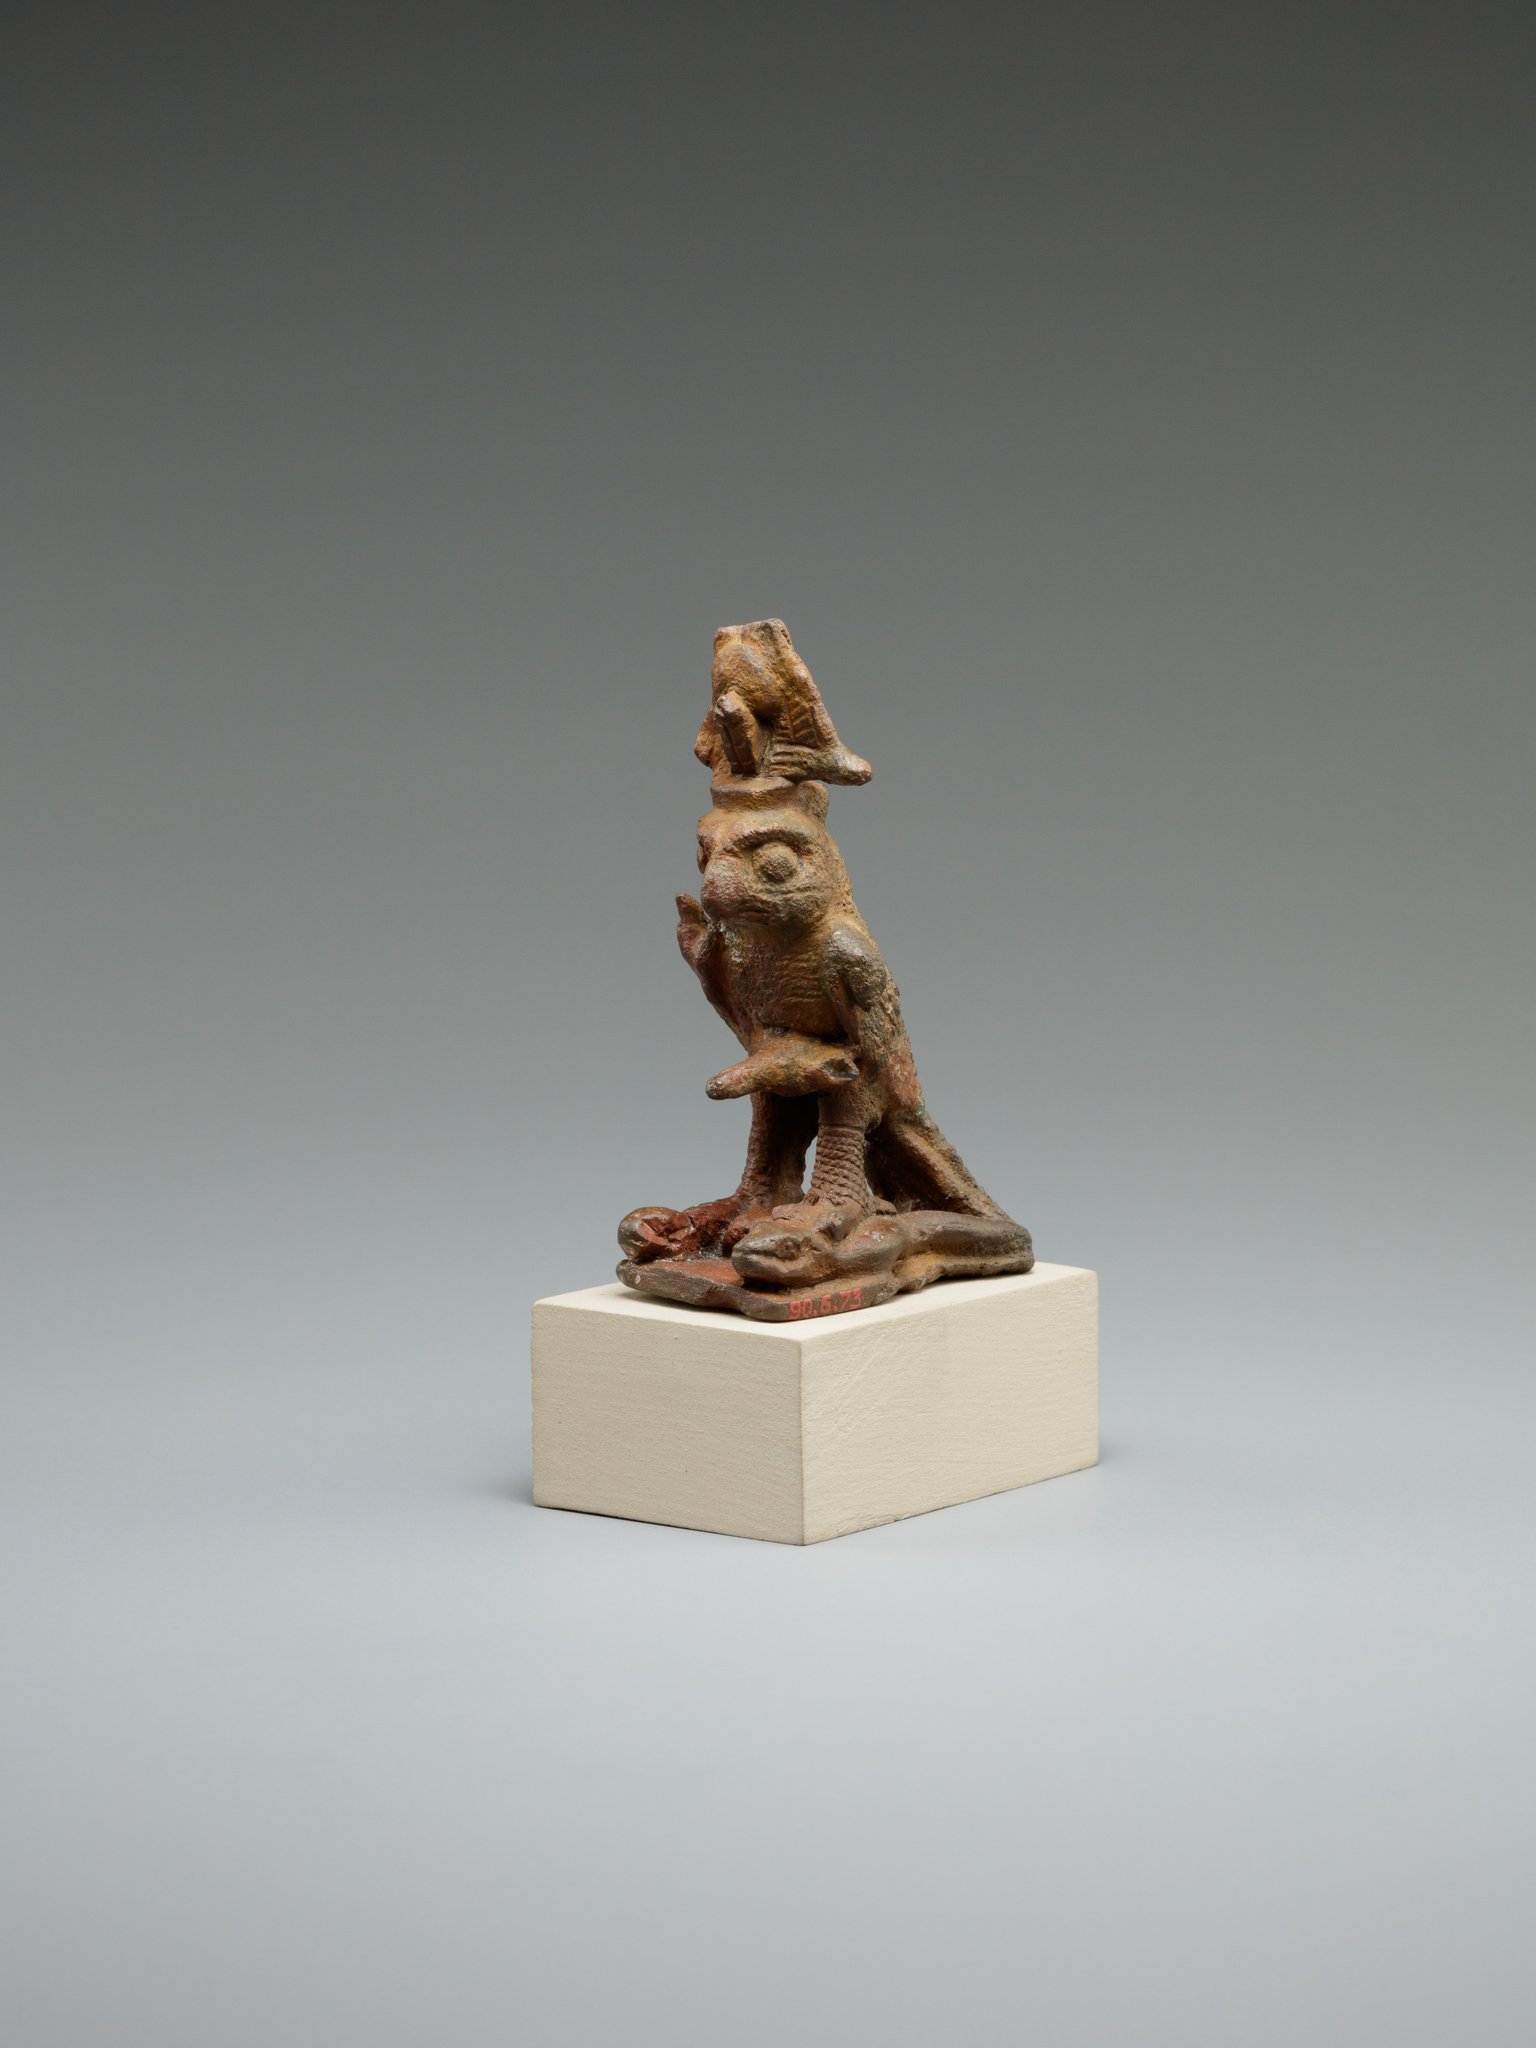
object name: figurine, falcon, ithyphallic, snake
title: Ithyphallic falcon treading on two snakes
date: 343-330 BCE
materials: alloy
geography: egypt